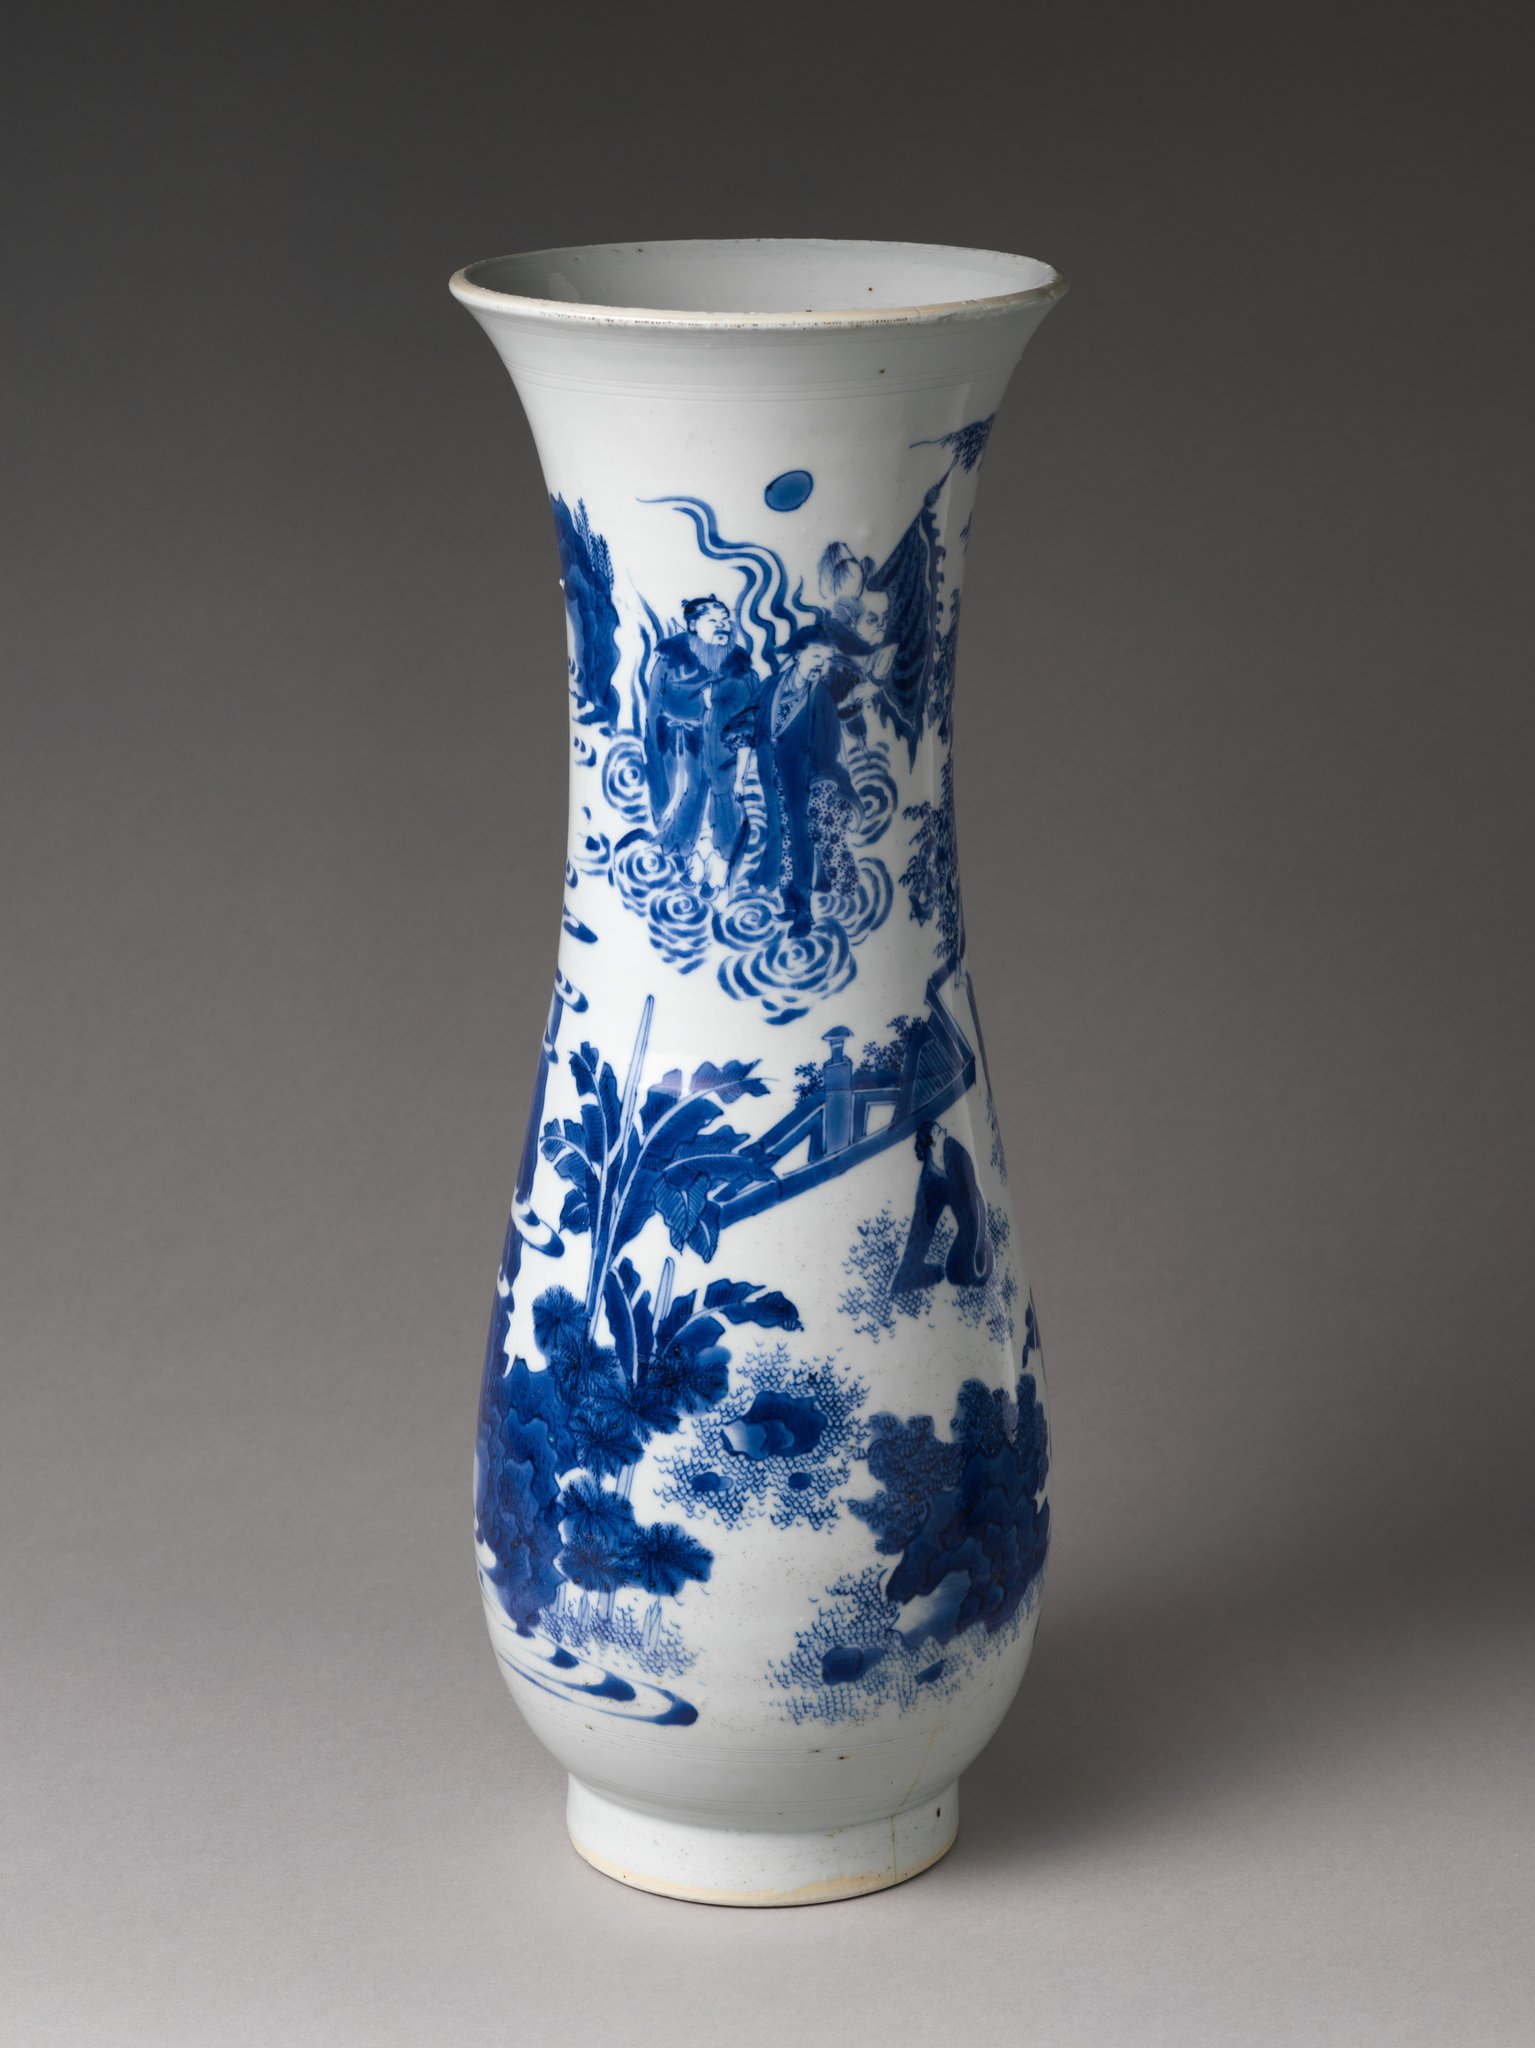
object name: vase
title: Vase with Figures in Landscape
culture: chinese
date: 1634-1666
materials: cobalt, glaze, porcelain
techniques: incising, painting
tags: men,women,trees